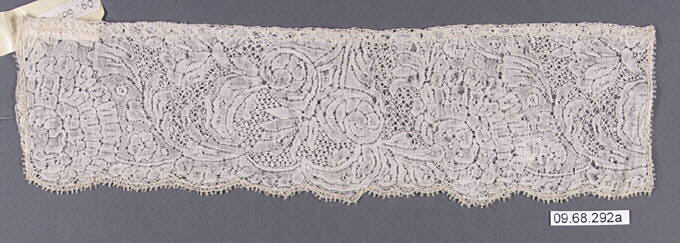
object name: fragment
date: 1667-1733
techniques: lace